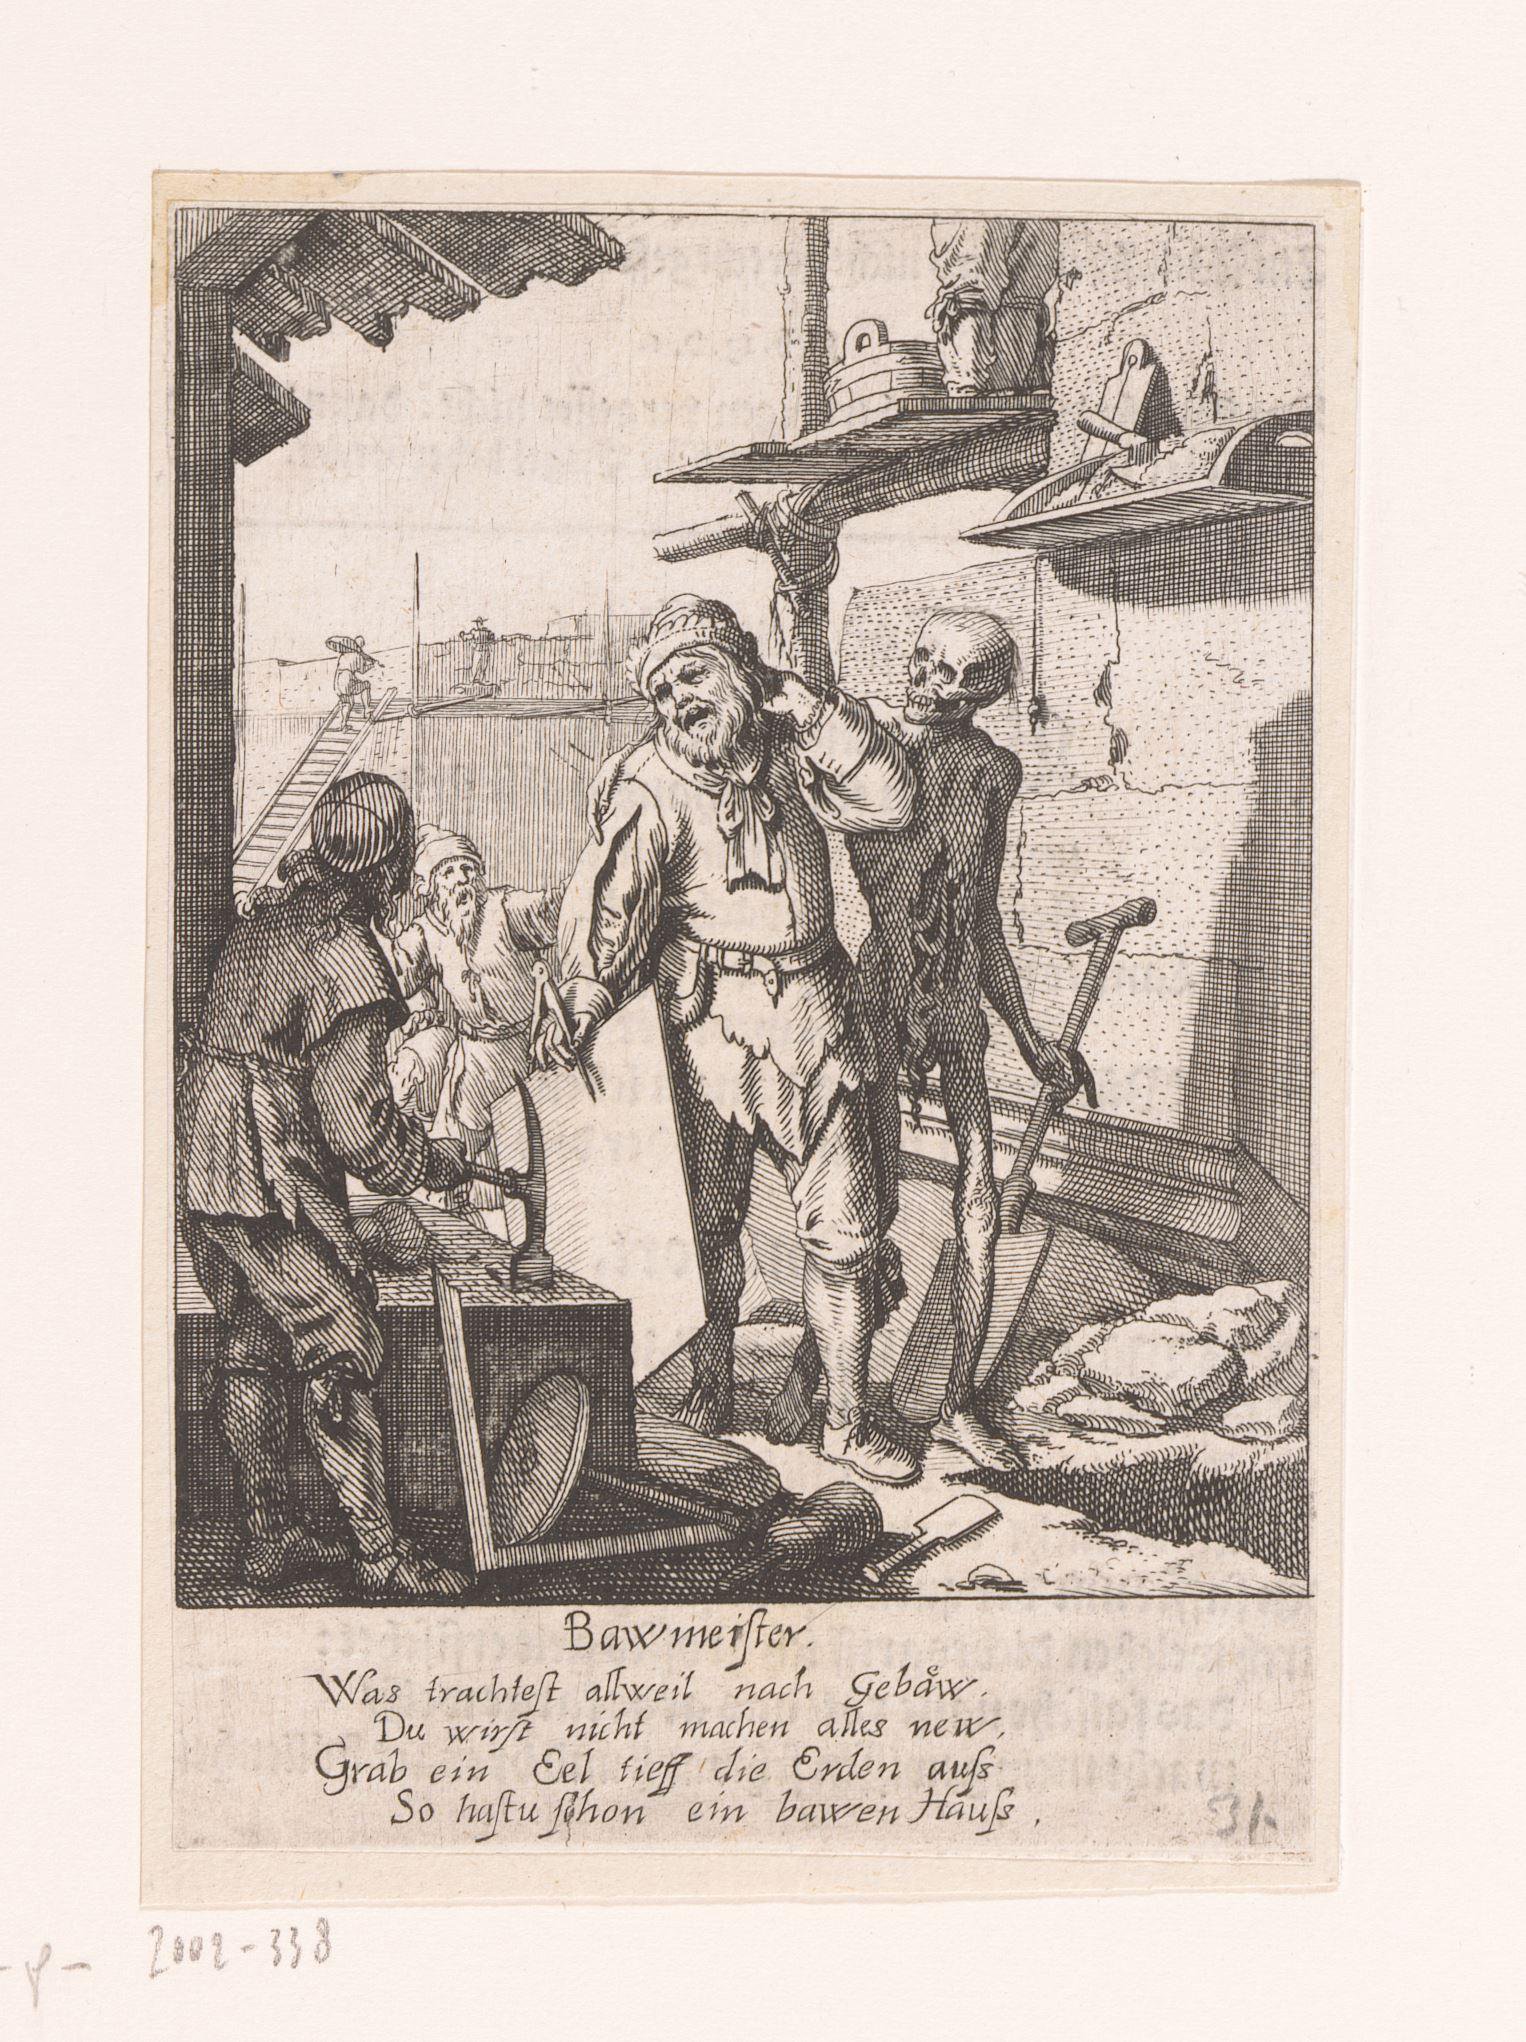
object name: print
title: Architect en de Dood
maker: johann jakob bodmer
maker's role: printer, publisher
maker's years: 1629-1650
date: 1650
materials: paper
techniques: etching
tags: personifications of death; 'morte' (ripa), dance of death; death together with one or more human beings, astrologer at work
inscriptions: collector's mark: Lugt 2233, collector's mark: Lugt 2228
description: Prent uit: Meyer, Rudolph. Sterbenspiegel, das ist sonnenklare Vorstellung menschlicher Nichtigkeit durch alle Ständ und Geschlechter (...). Zürich: J.J. Bodmer, 1650.